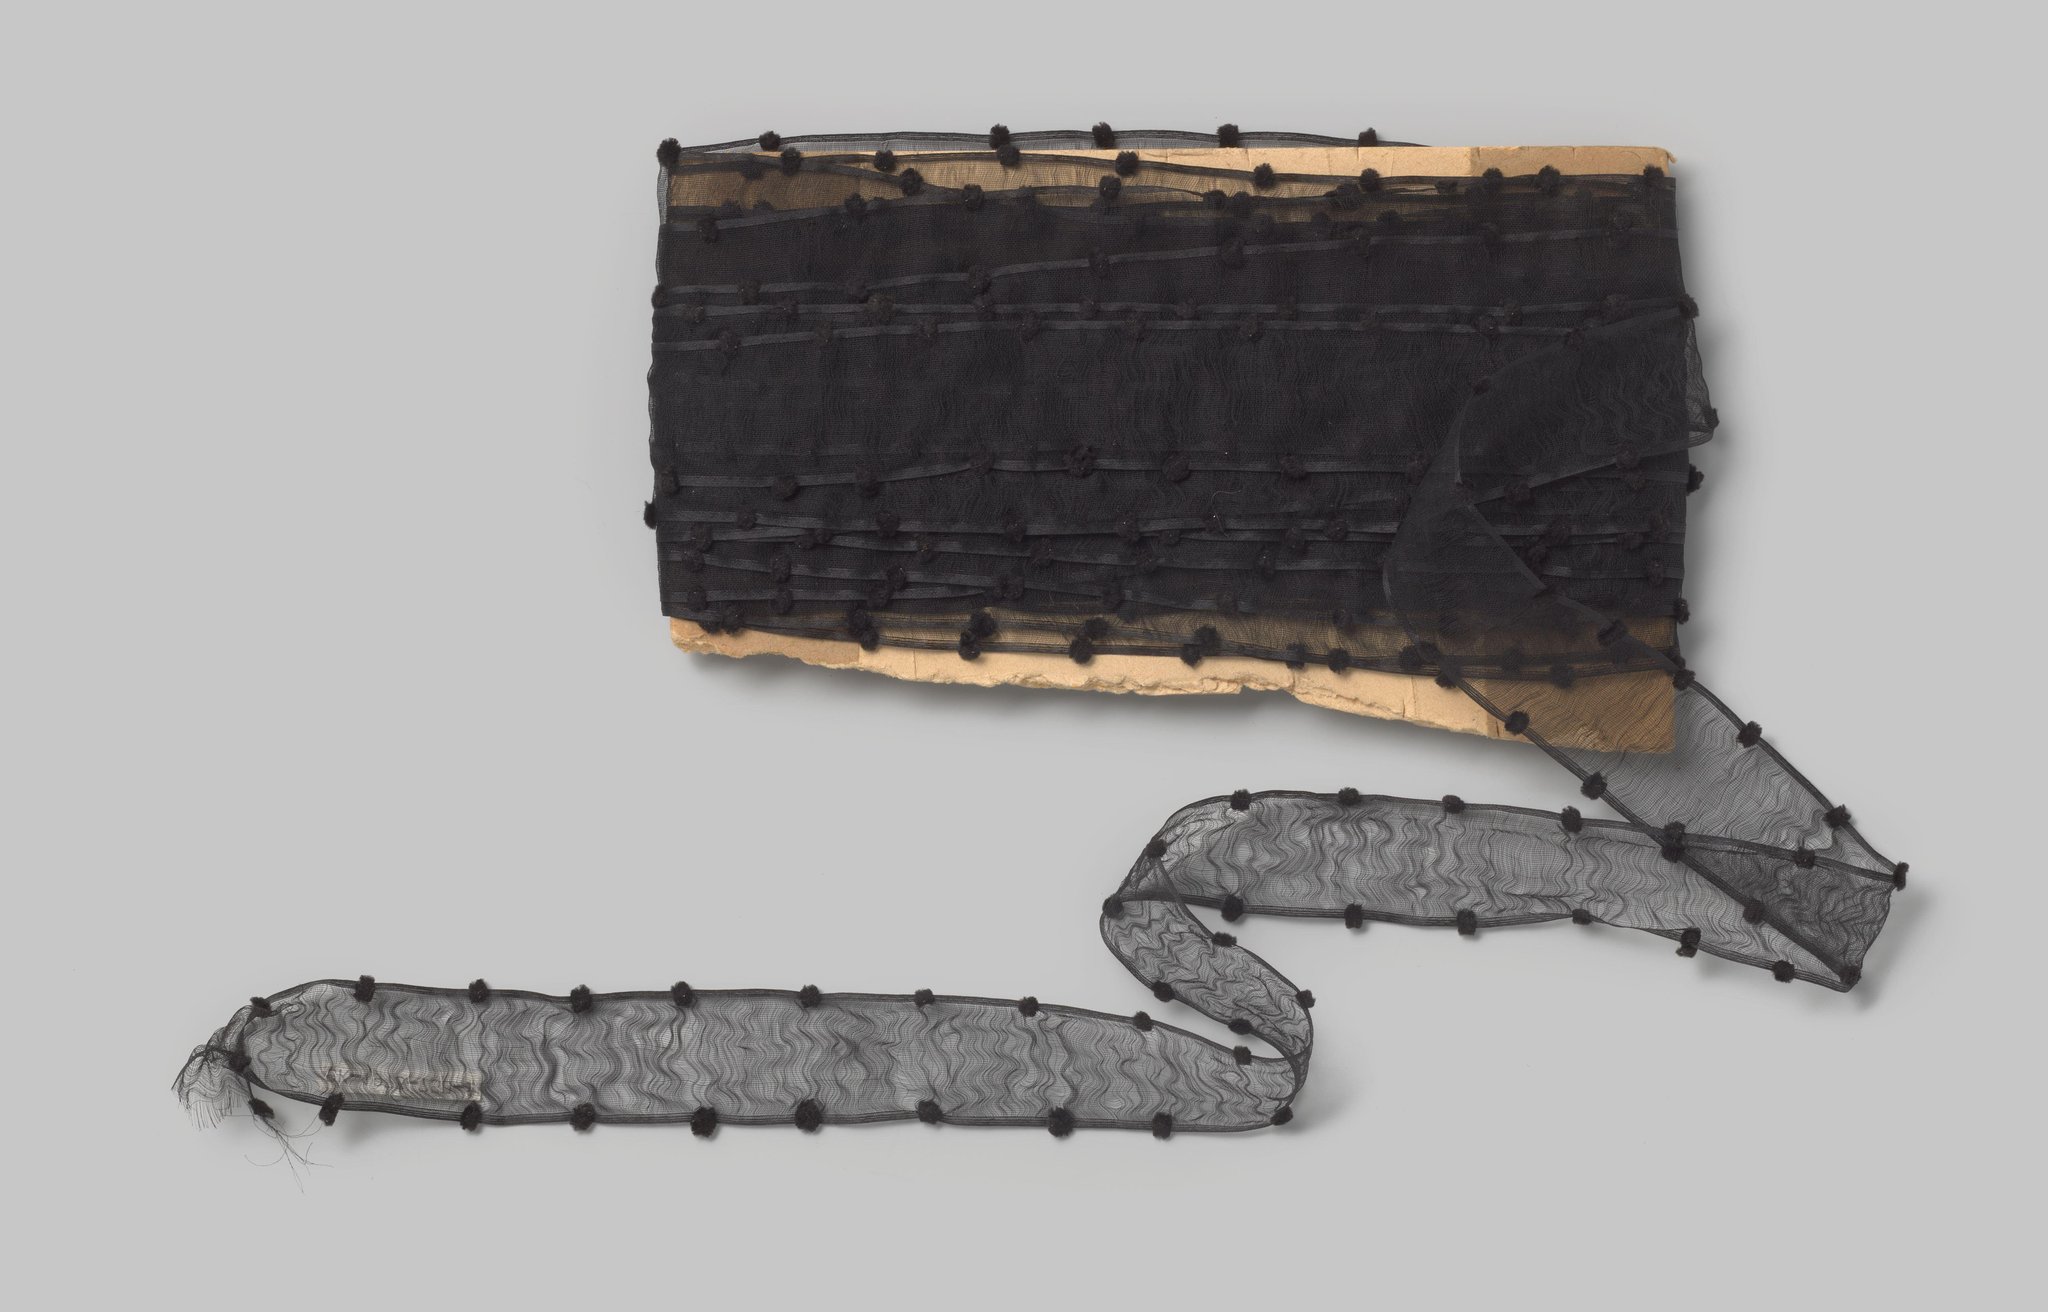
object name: ribbon material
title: Karton waarop lint van zwart zijden gaas met aan beide randen iedere twee cm een zwart fluwelen bol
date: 1900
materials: silk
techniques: weave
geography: nijmegen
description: Karton waarop lint van zwart zijden gaas met aan beide randen iedere twee cm een zwart fluwelen bol.